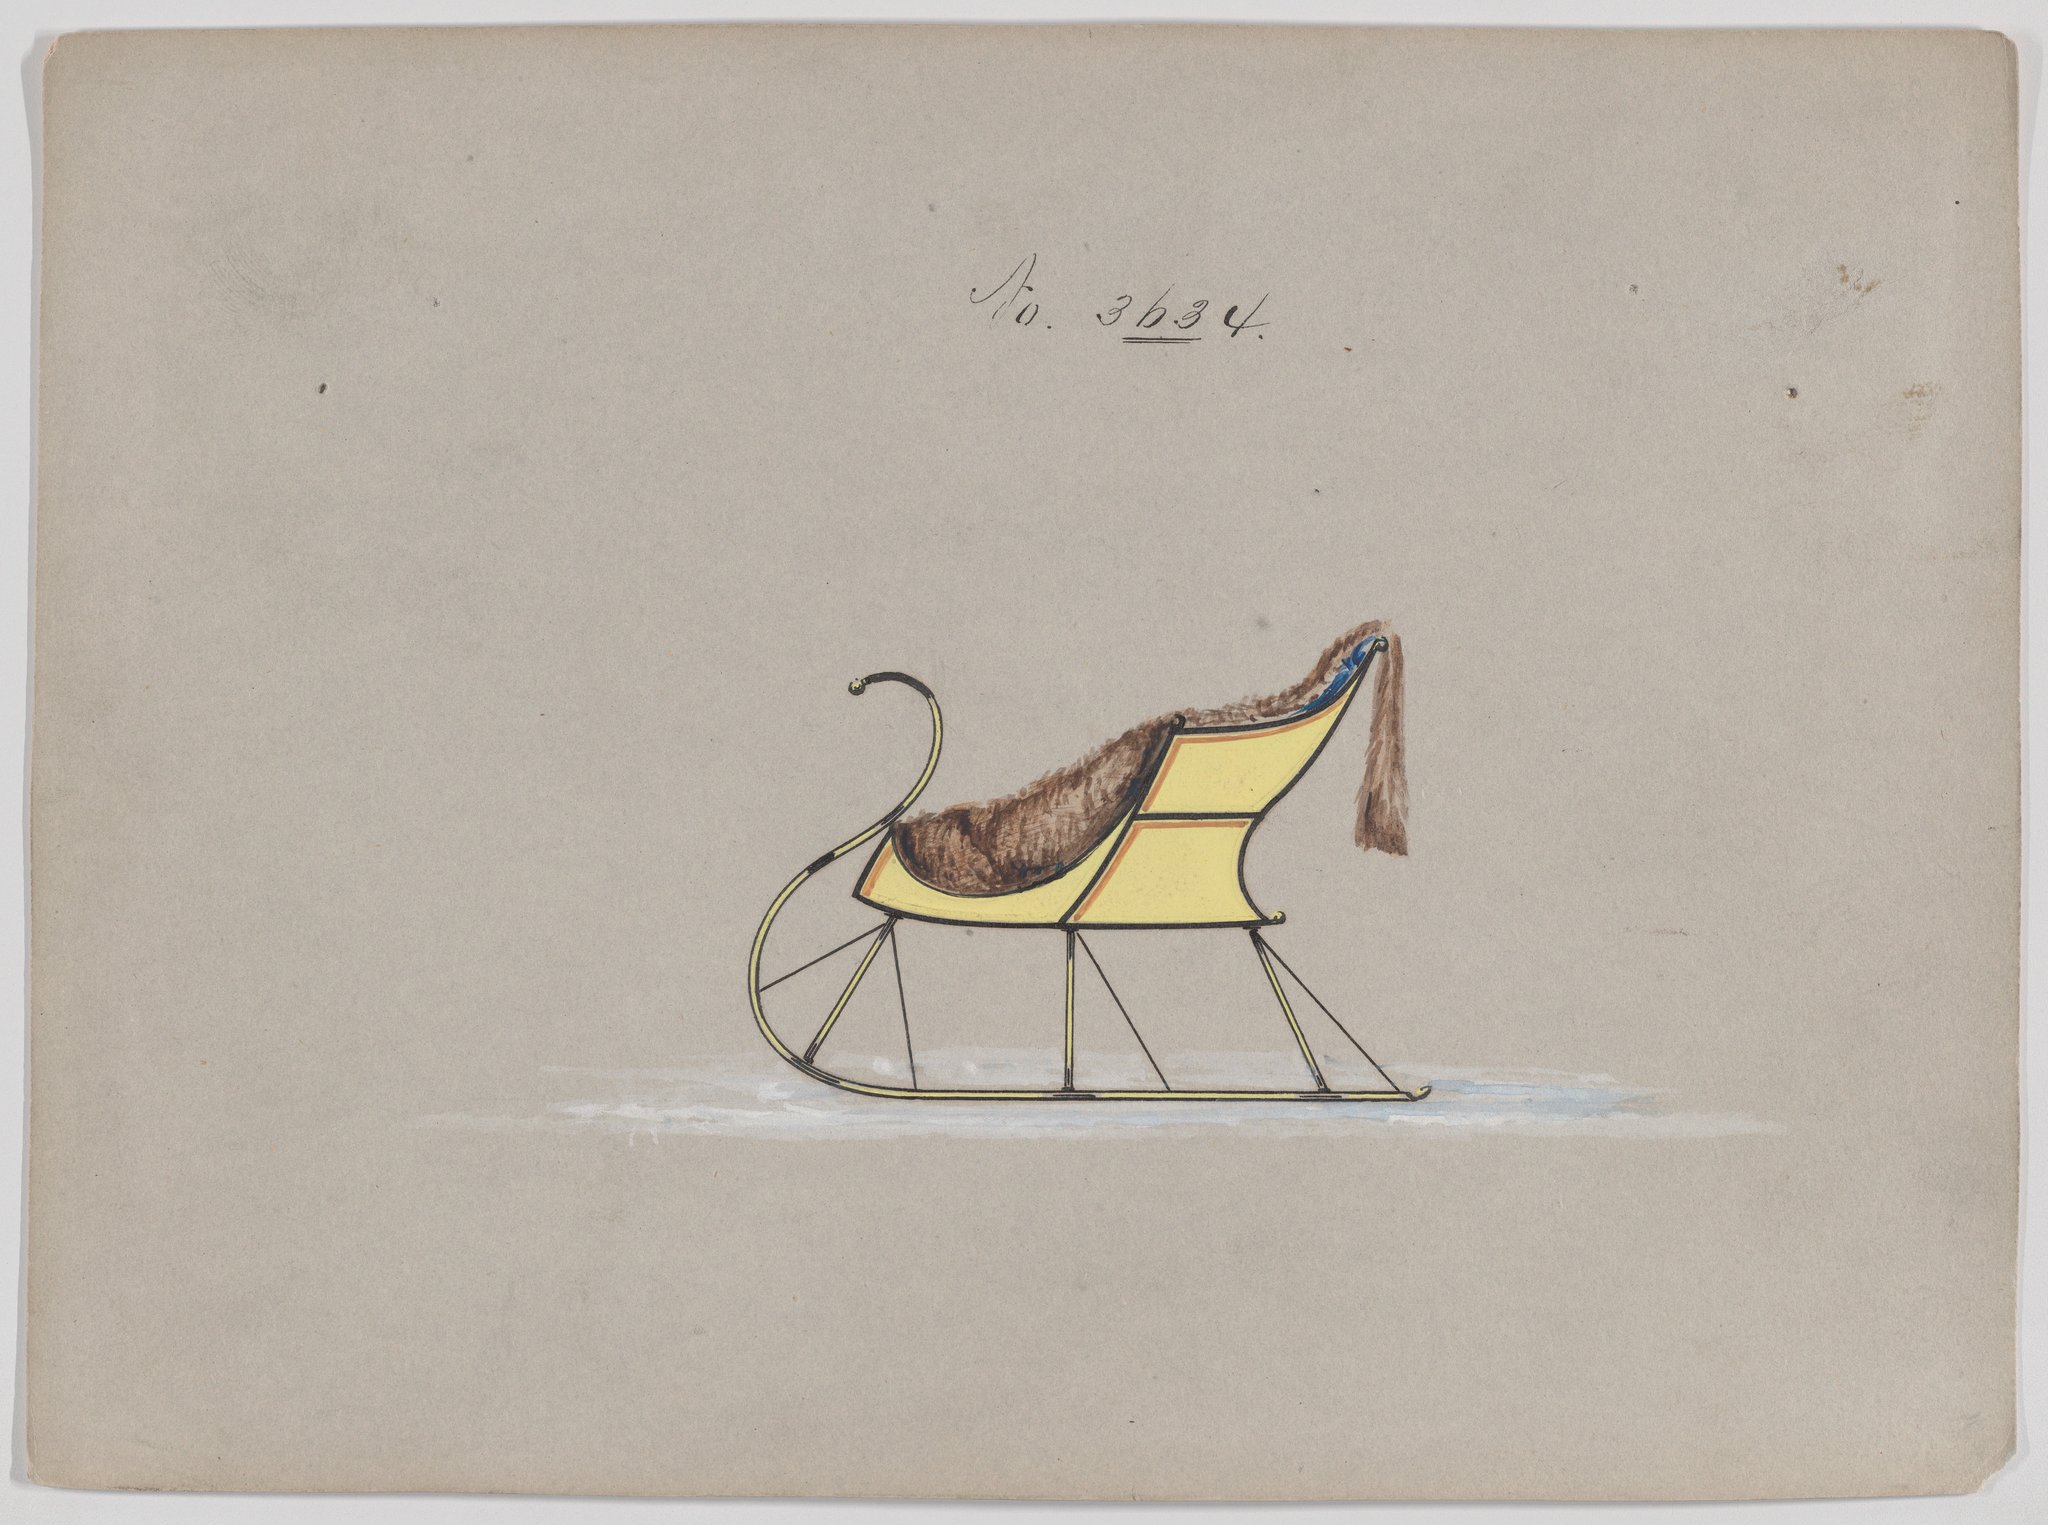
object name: drawing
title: Cutter #3634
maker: brewster & co.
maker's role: manufacturer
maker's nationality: american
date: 1880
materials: gouache, ink, watercolor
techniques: pen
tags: sleighs